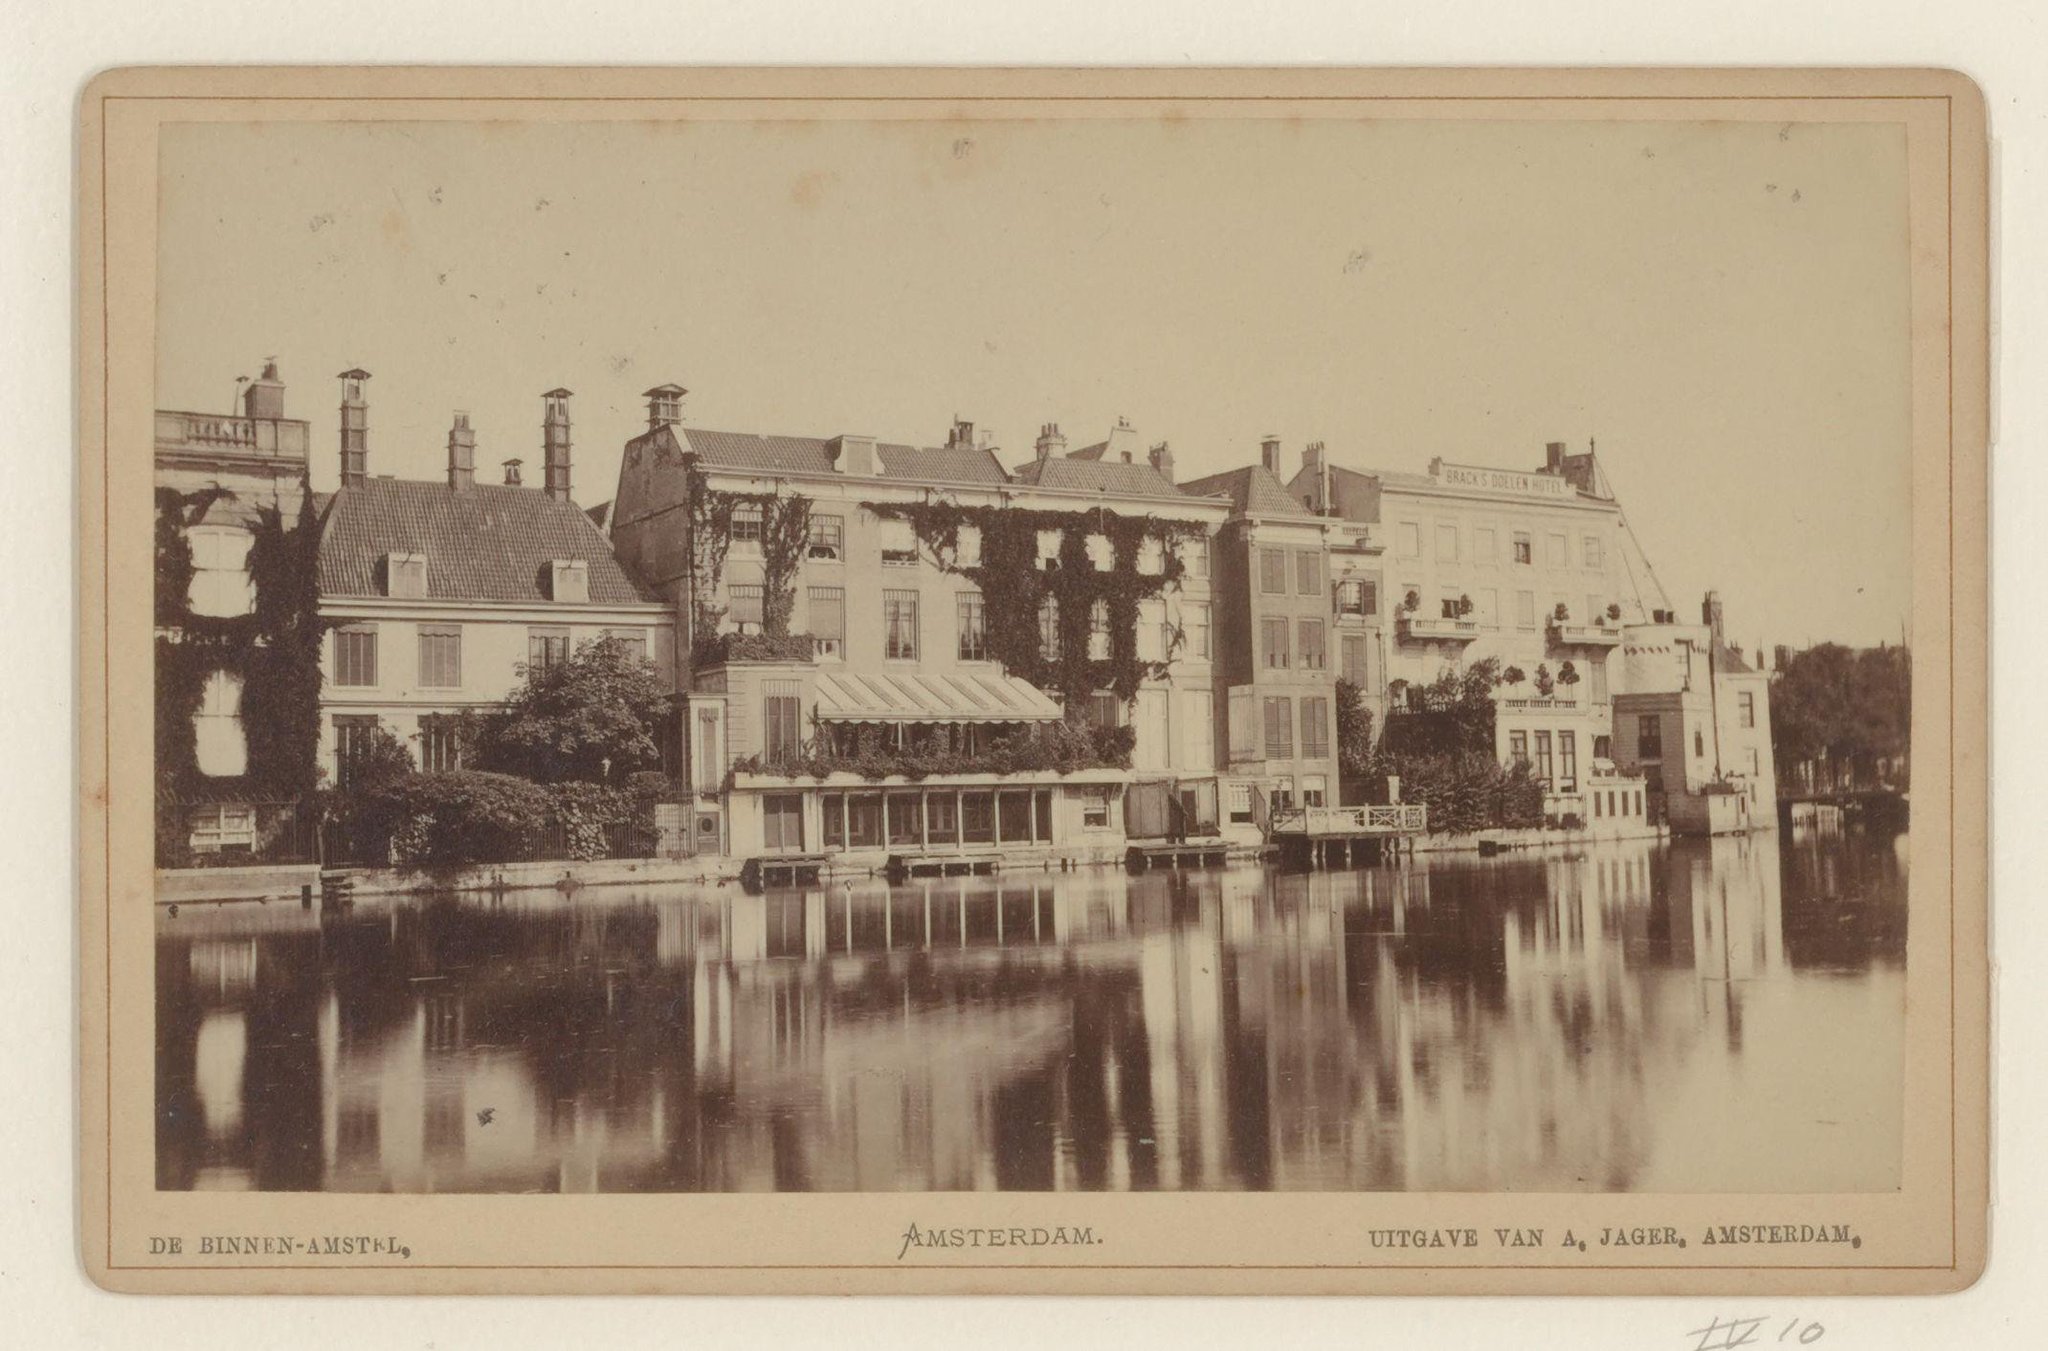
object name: cabinet photograph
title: Gezicht op de Binnen-Amstel bij de achterzijde van de Doelenstraat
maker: andries jager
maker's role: publisher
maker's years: 1825-1905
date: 1875-1896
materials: cardboard, paper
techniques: albumen print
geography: amsterdam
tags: city-view in general; 'veduta', canal, the usual house or row of houses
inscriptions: inscription: ‘Binnen-Amstel achterzijde v/d / Doelenstraat’, collector's mark: ‘4’ Lugt 1641b, stamp: ‘Gebr. Douwes / Atelier / Groenburgwal 15 / Amsterdam’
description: Onderwerpsrubriek binnen de Atlas Amsterdam: Amstel van Doelensluis tot Blauwbrug.